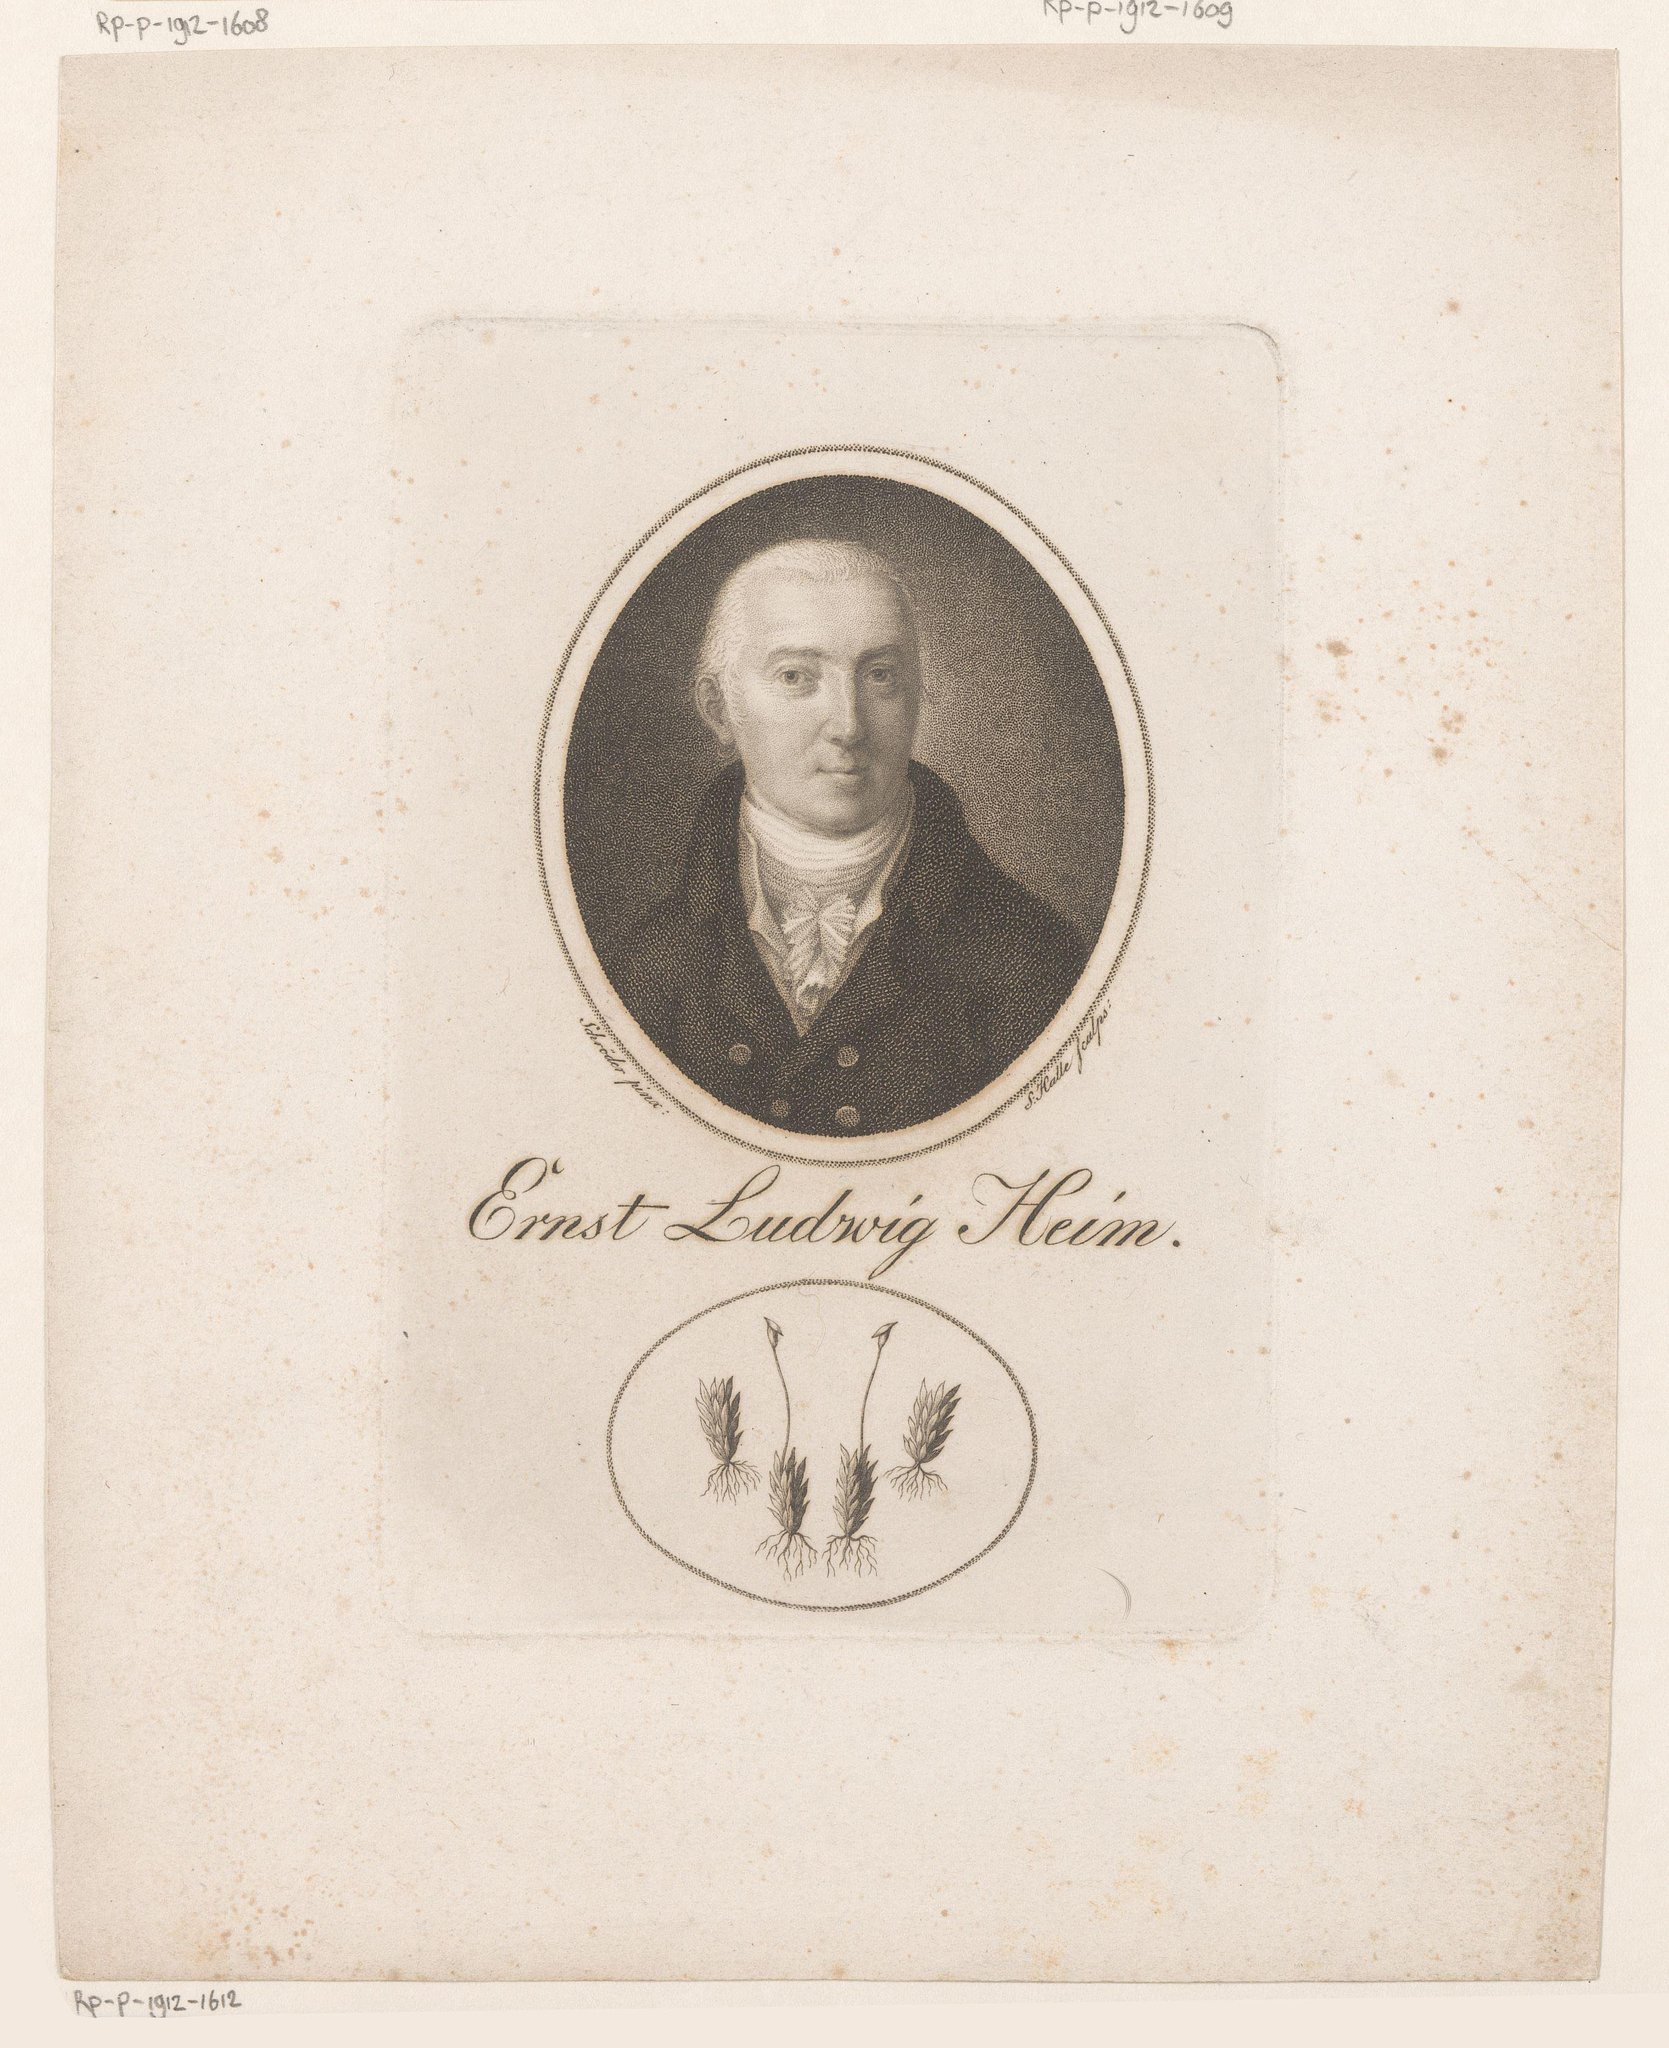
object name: print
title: Portret van Ernst Ludwig Heim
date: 1757-1834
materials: paper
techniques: engraving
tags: berlin, mosses, historical persons, physician, doctor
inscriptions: collector's mark: Lugt 2228